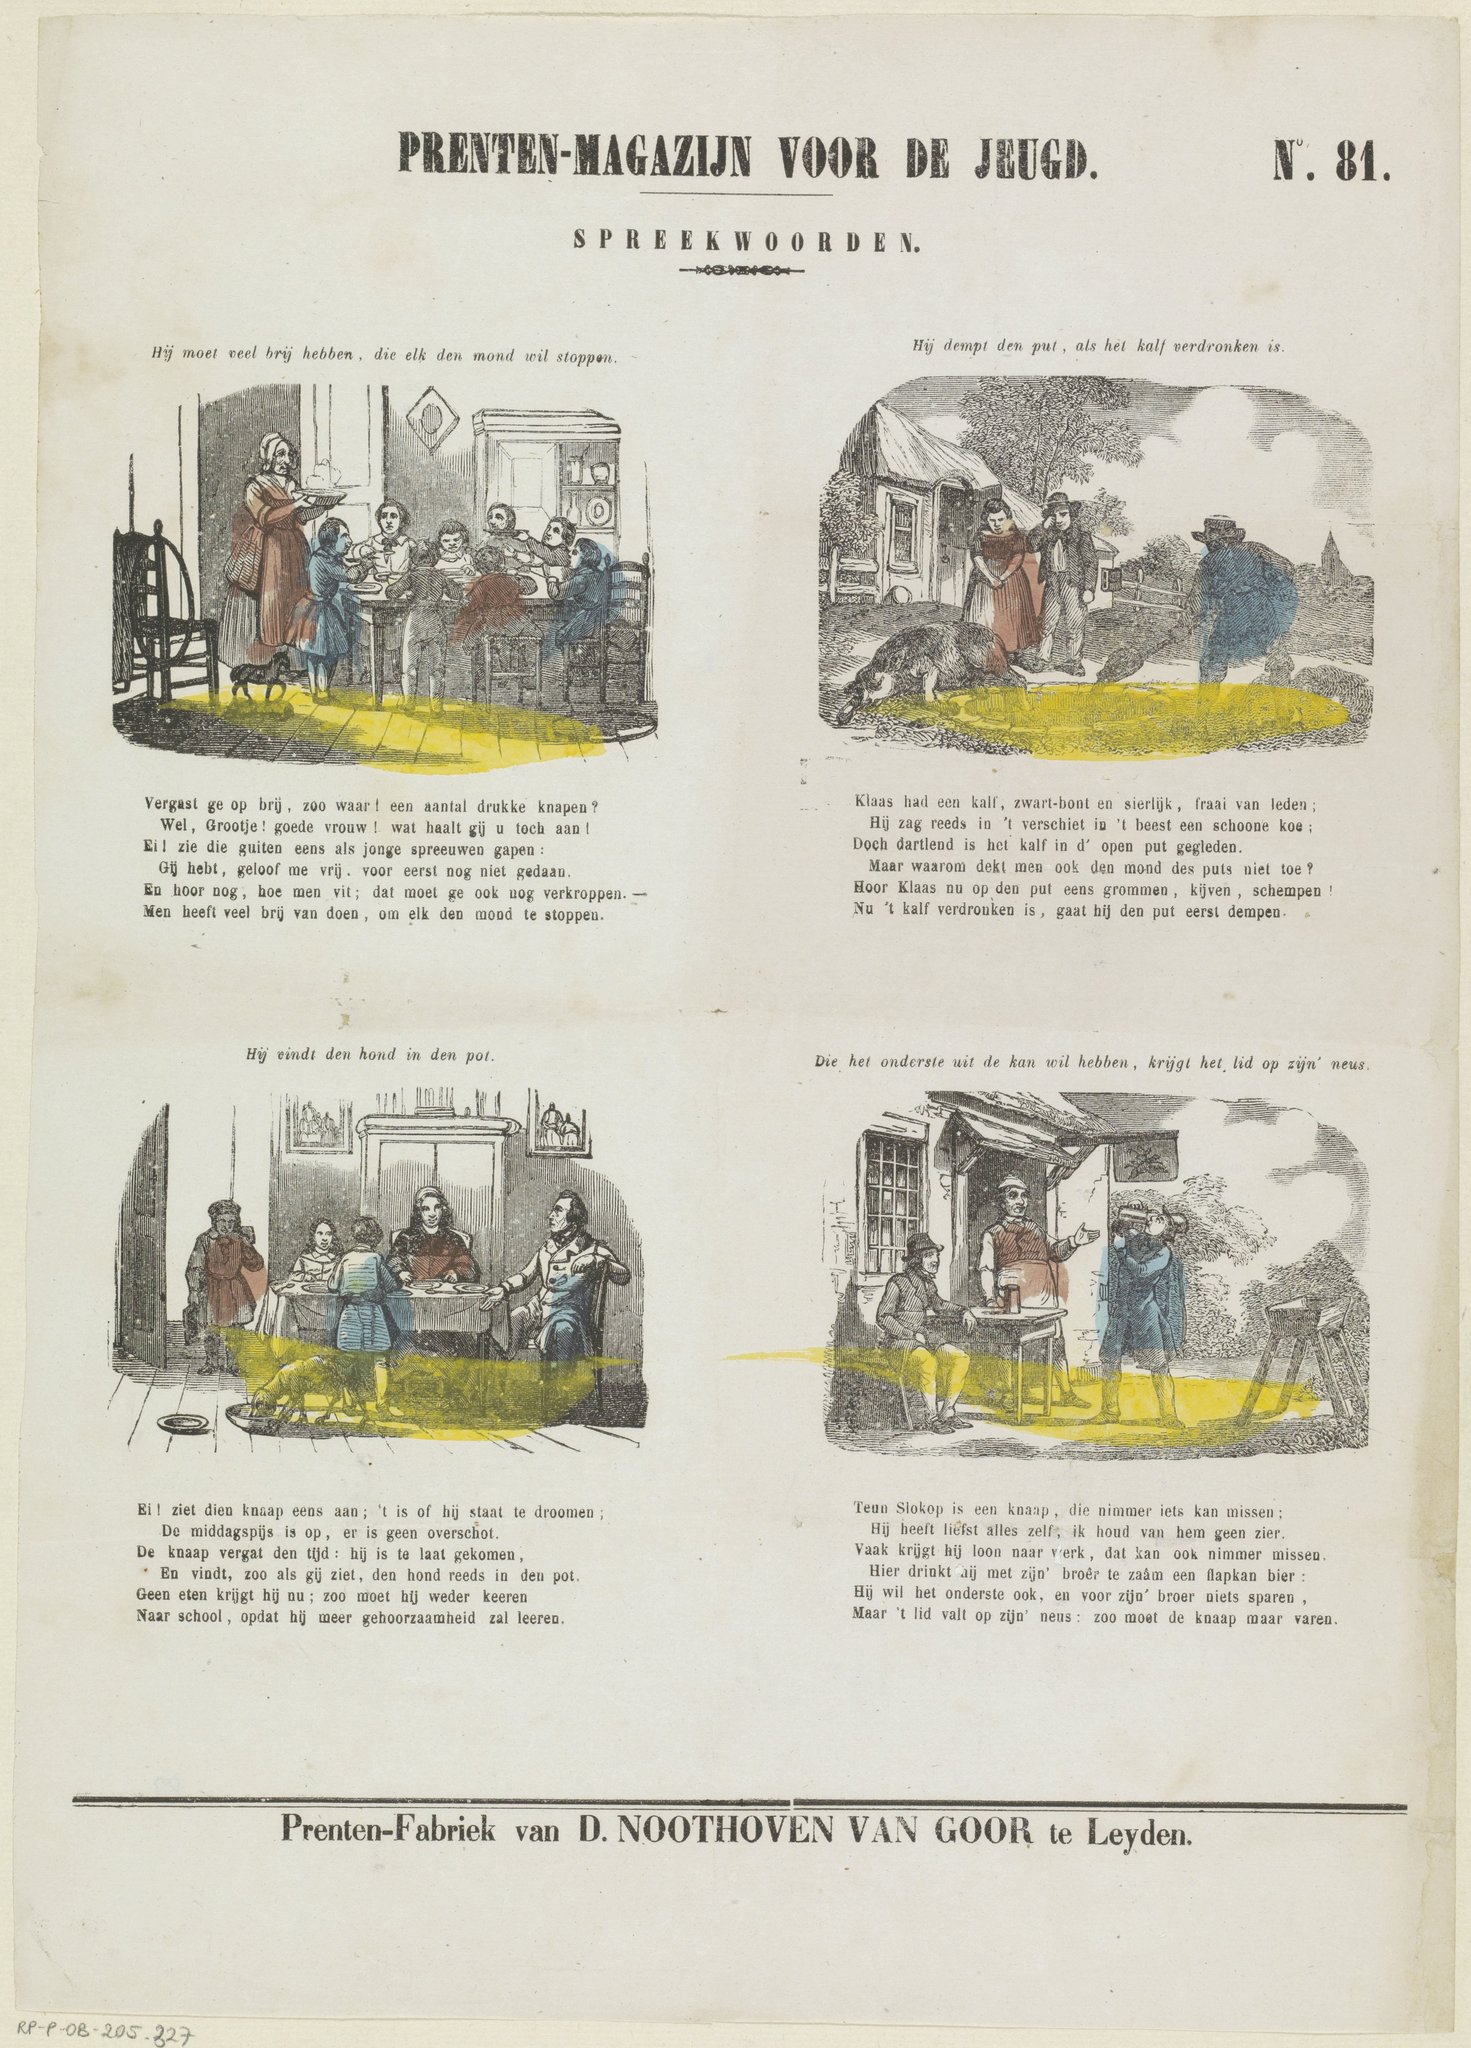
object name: print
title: Prenten-magazijn voor de jeugd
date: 1850-1881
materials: paper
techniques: colour, letterpress printing, engraving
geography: netherlands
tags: proverbs, sayings, etc.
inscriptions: collector's mark: Lugt 2760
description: Blad met 4 verbeeldingen van spreekwoorden. Boven elke voorstelling een titel en onder elke voorstelling een zesregelig vers. Genummerd rechtsboven: No. 81.